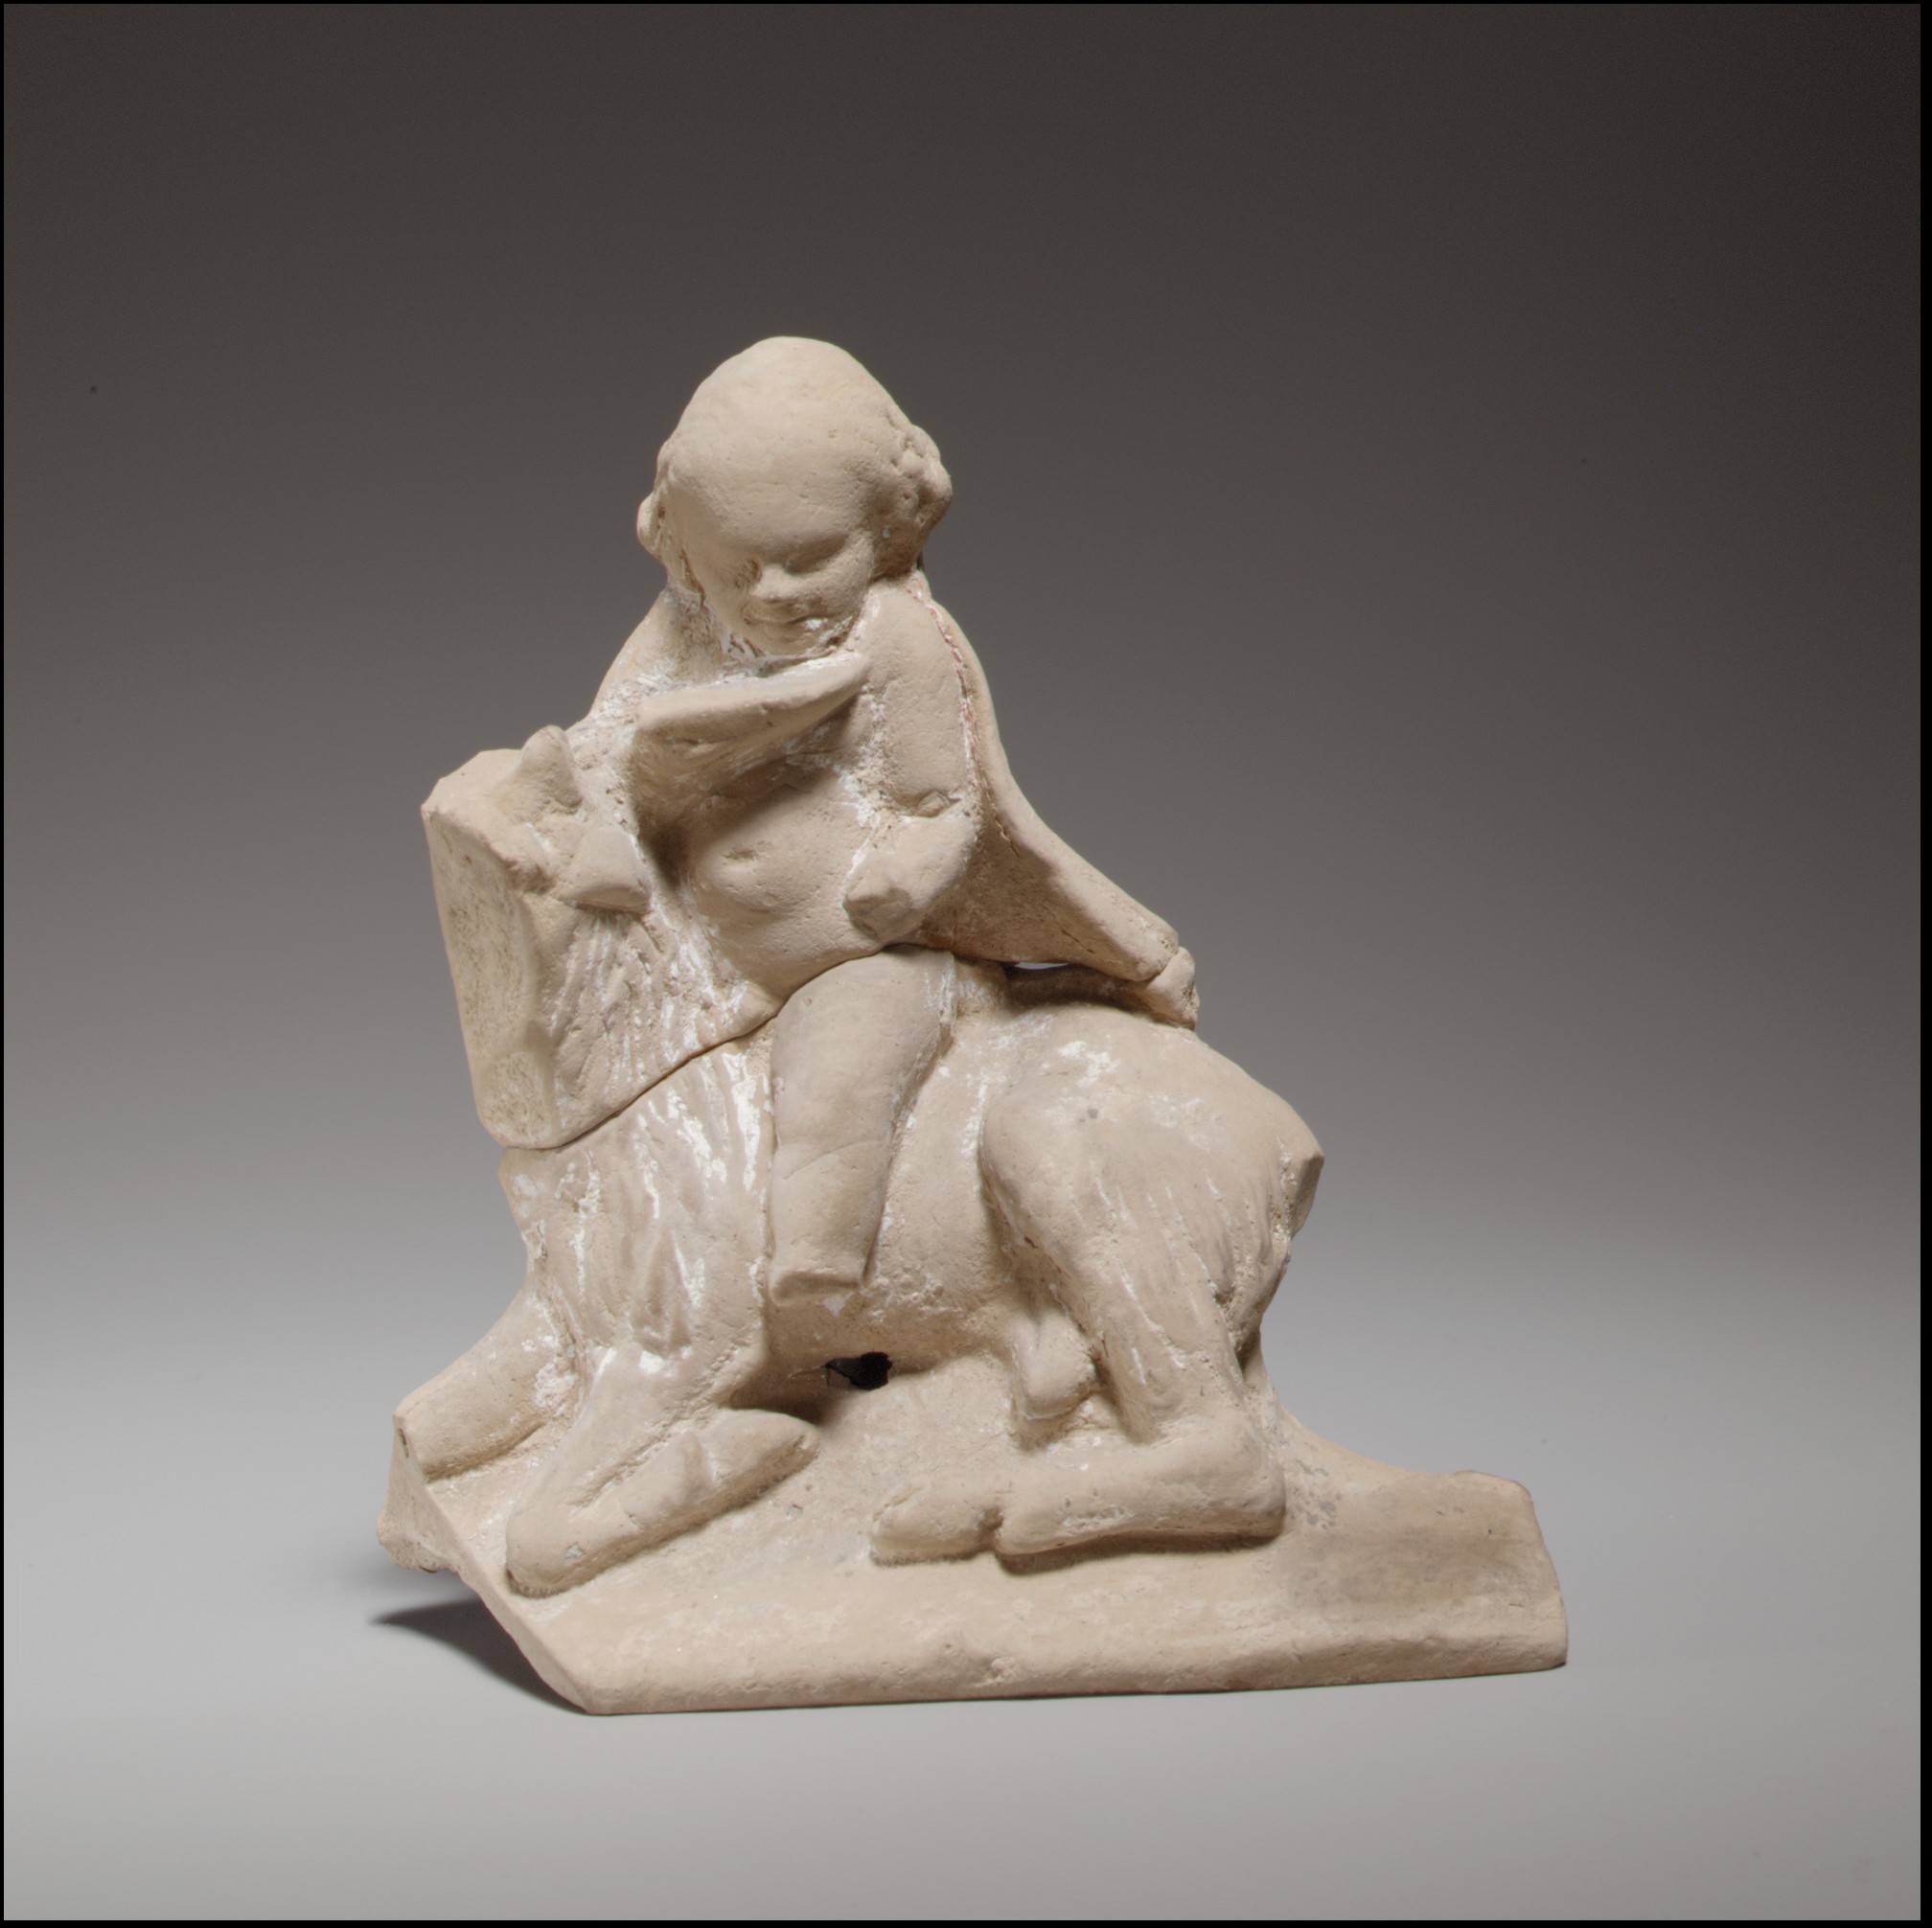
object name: statuette of eros riding a goat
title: Eros riding a goat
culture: cypriot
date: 201-300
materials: terracotta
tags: eros,goats